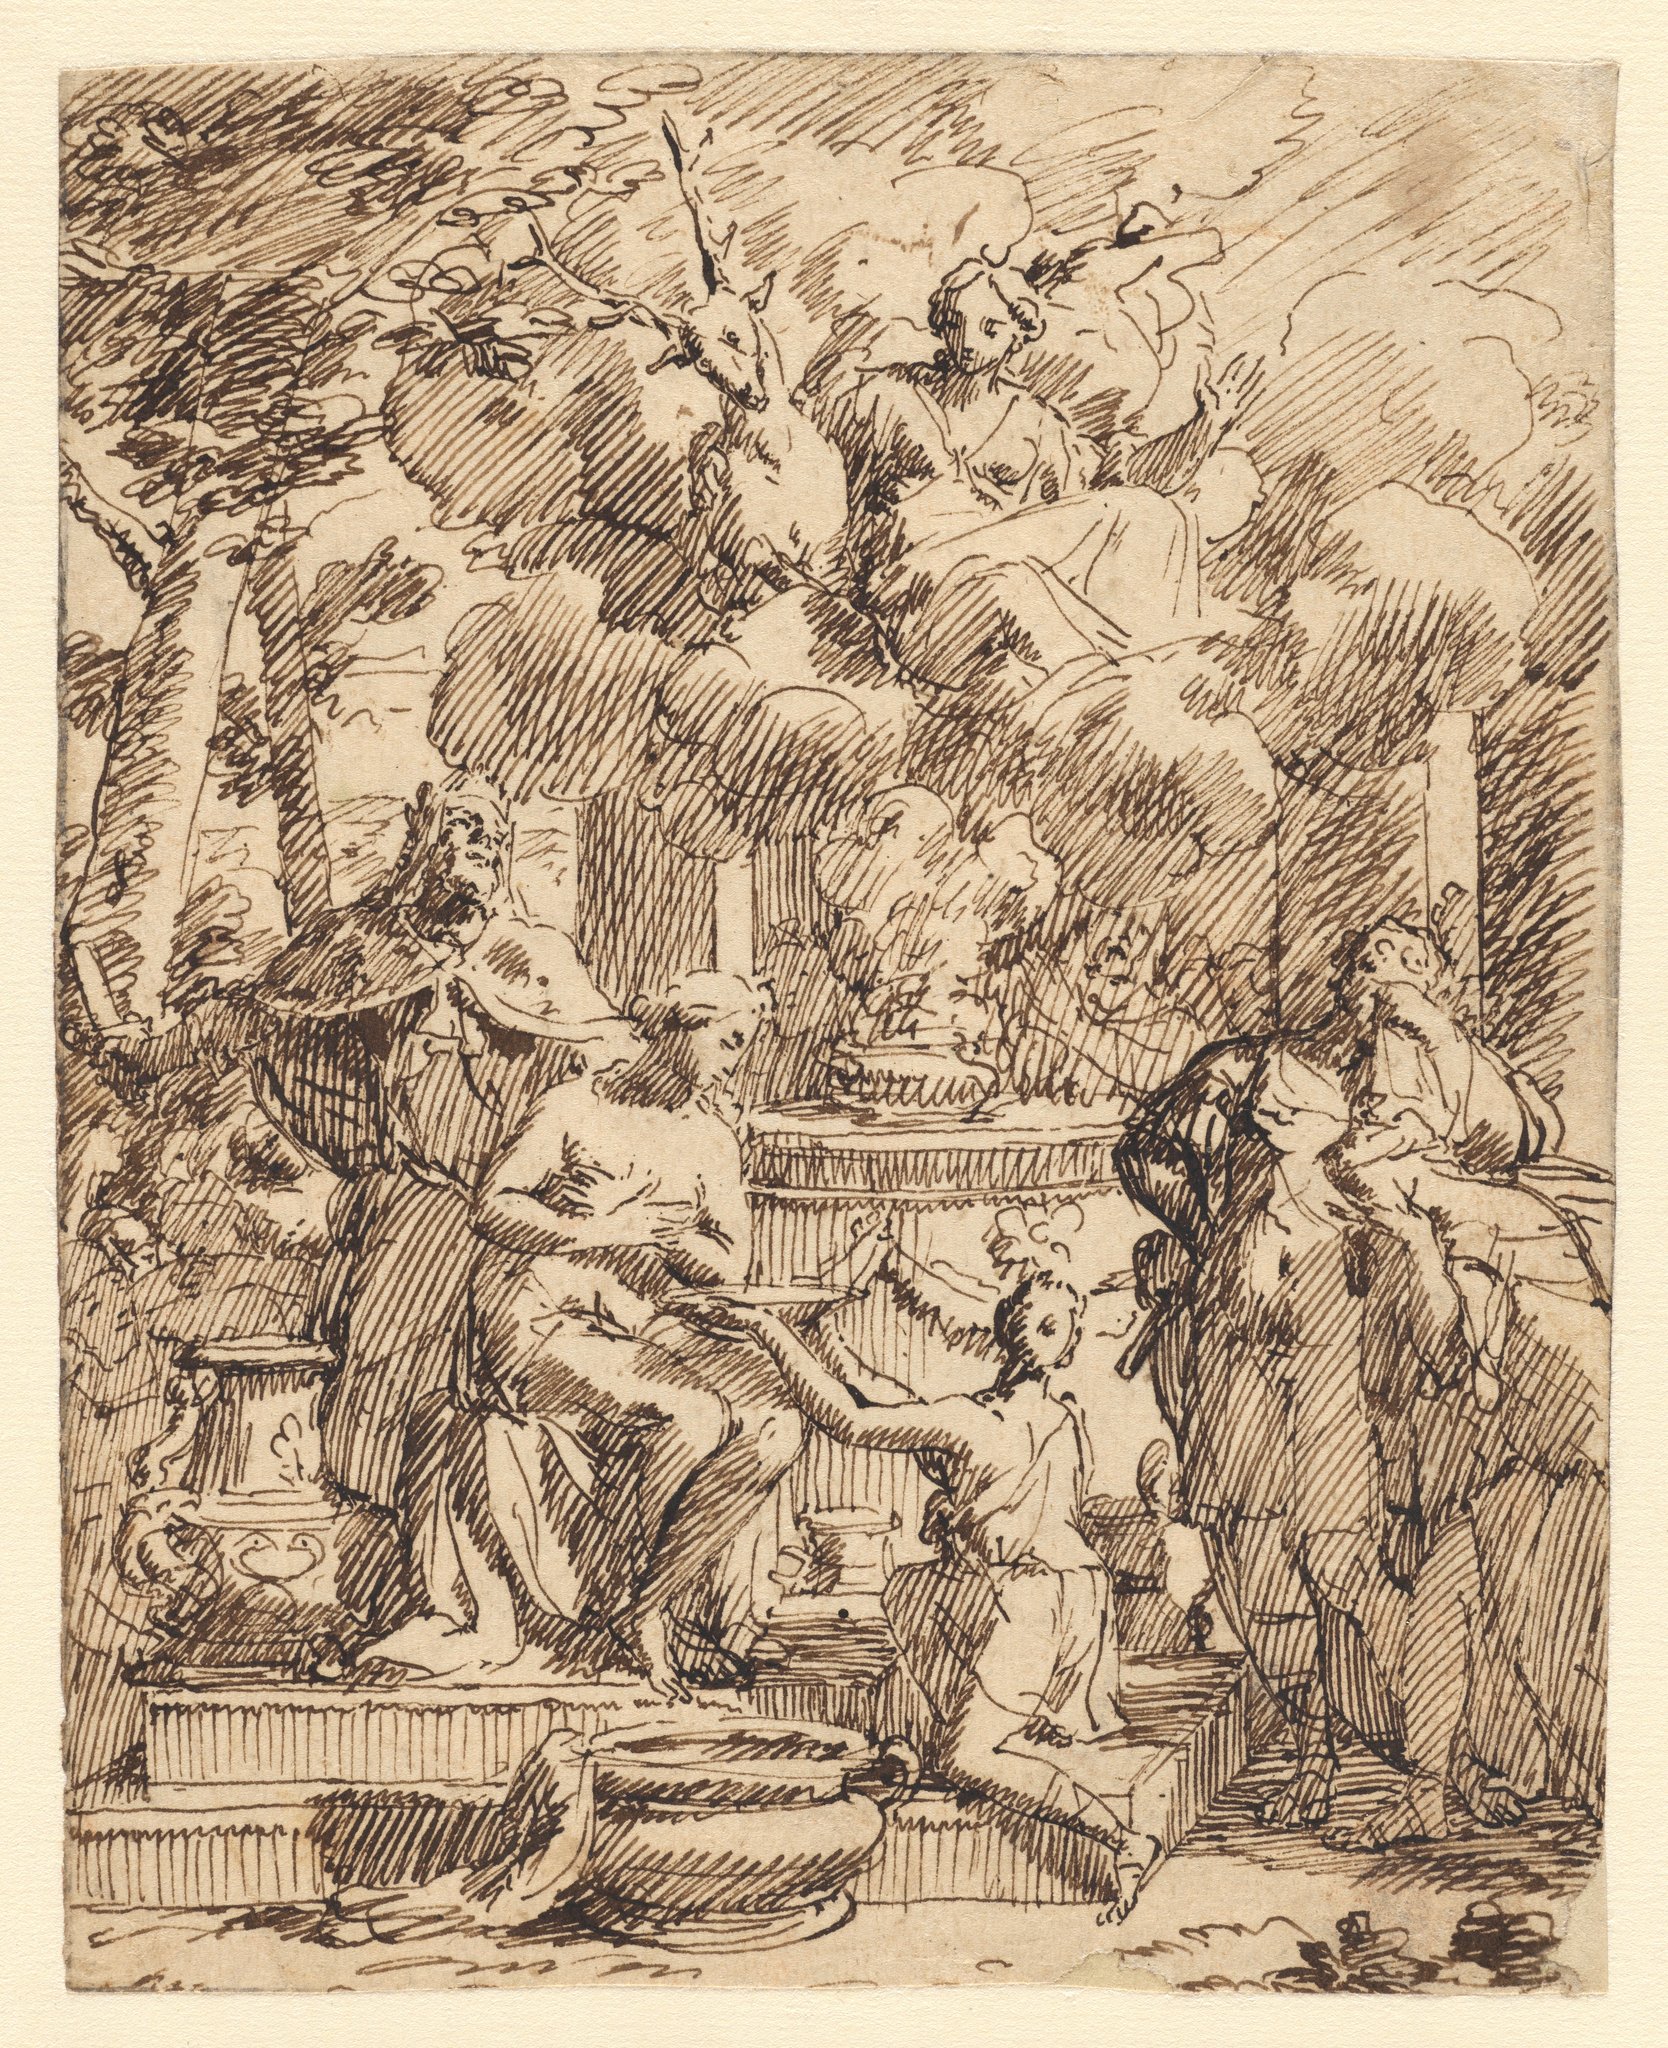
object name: drawing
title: The Sacrifice of Iphigenia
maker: gerard de lairesse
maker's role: artist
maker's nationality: dutch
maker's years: 1641-1711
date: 1667-1688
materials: ink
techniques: pen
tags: animals,men,iphigenia